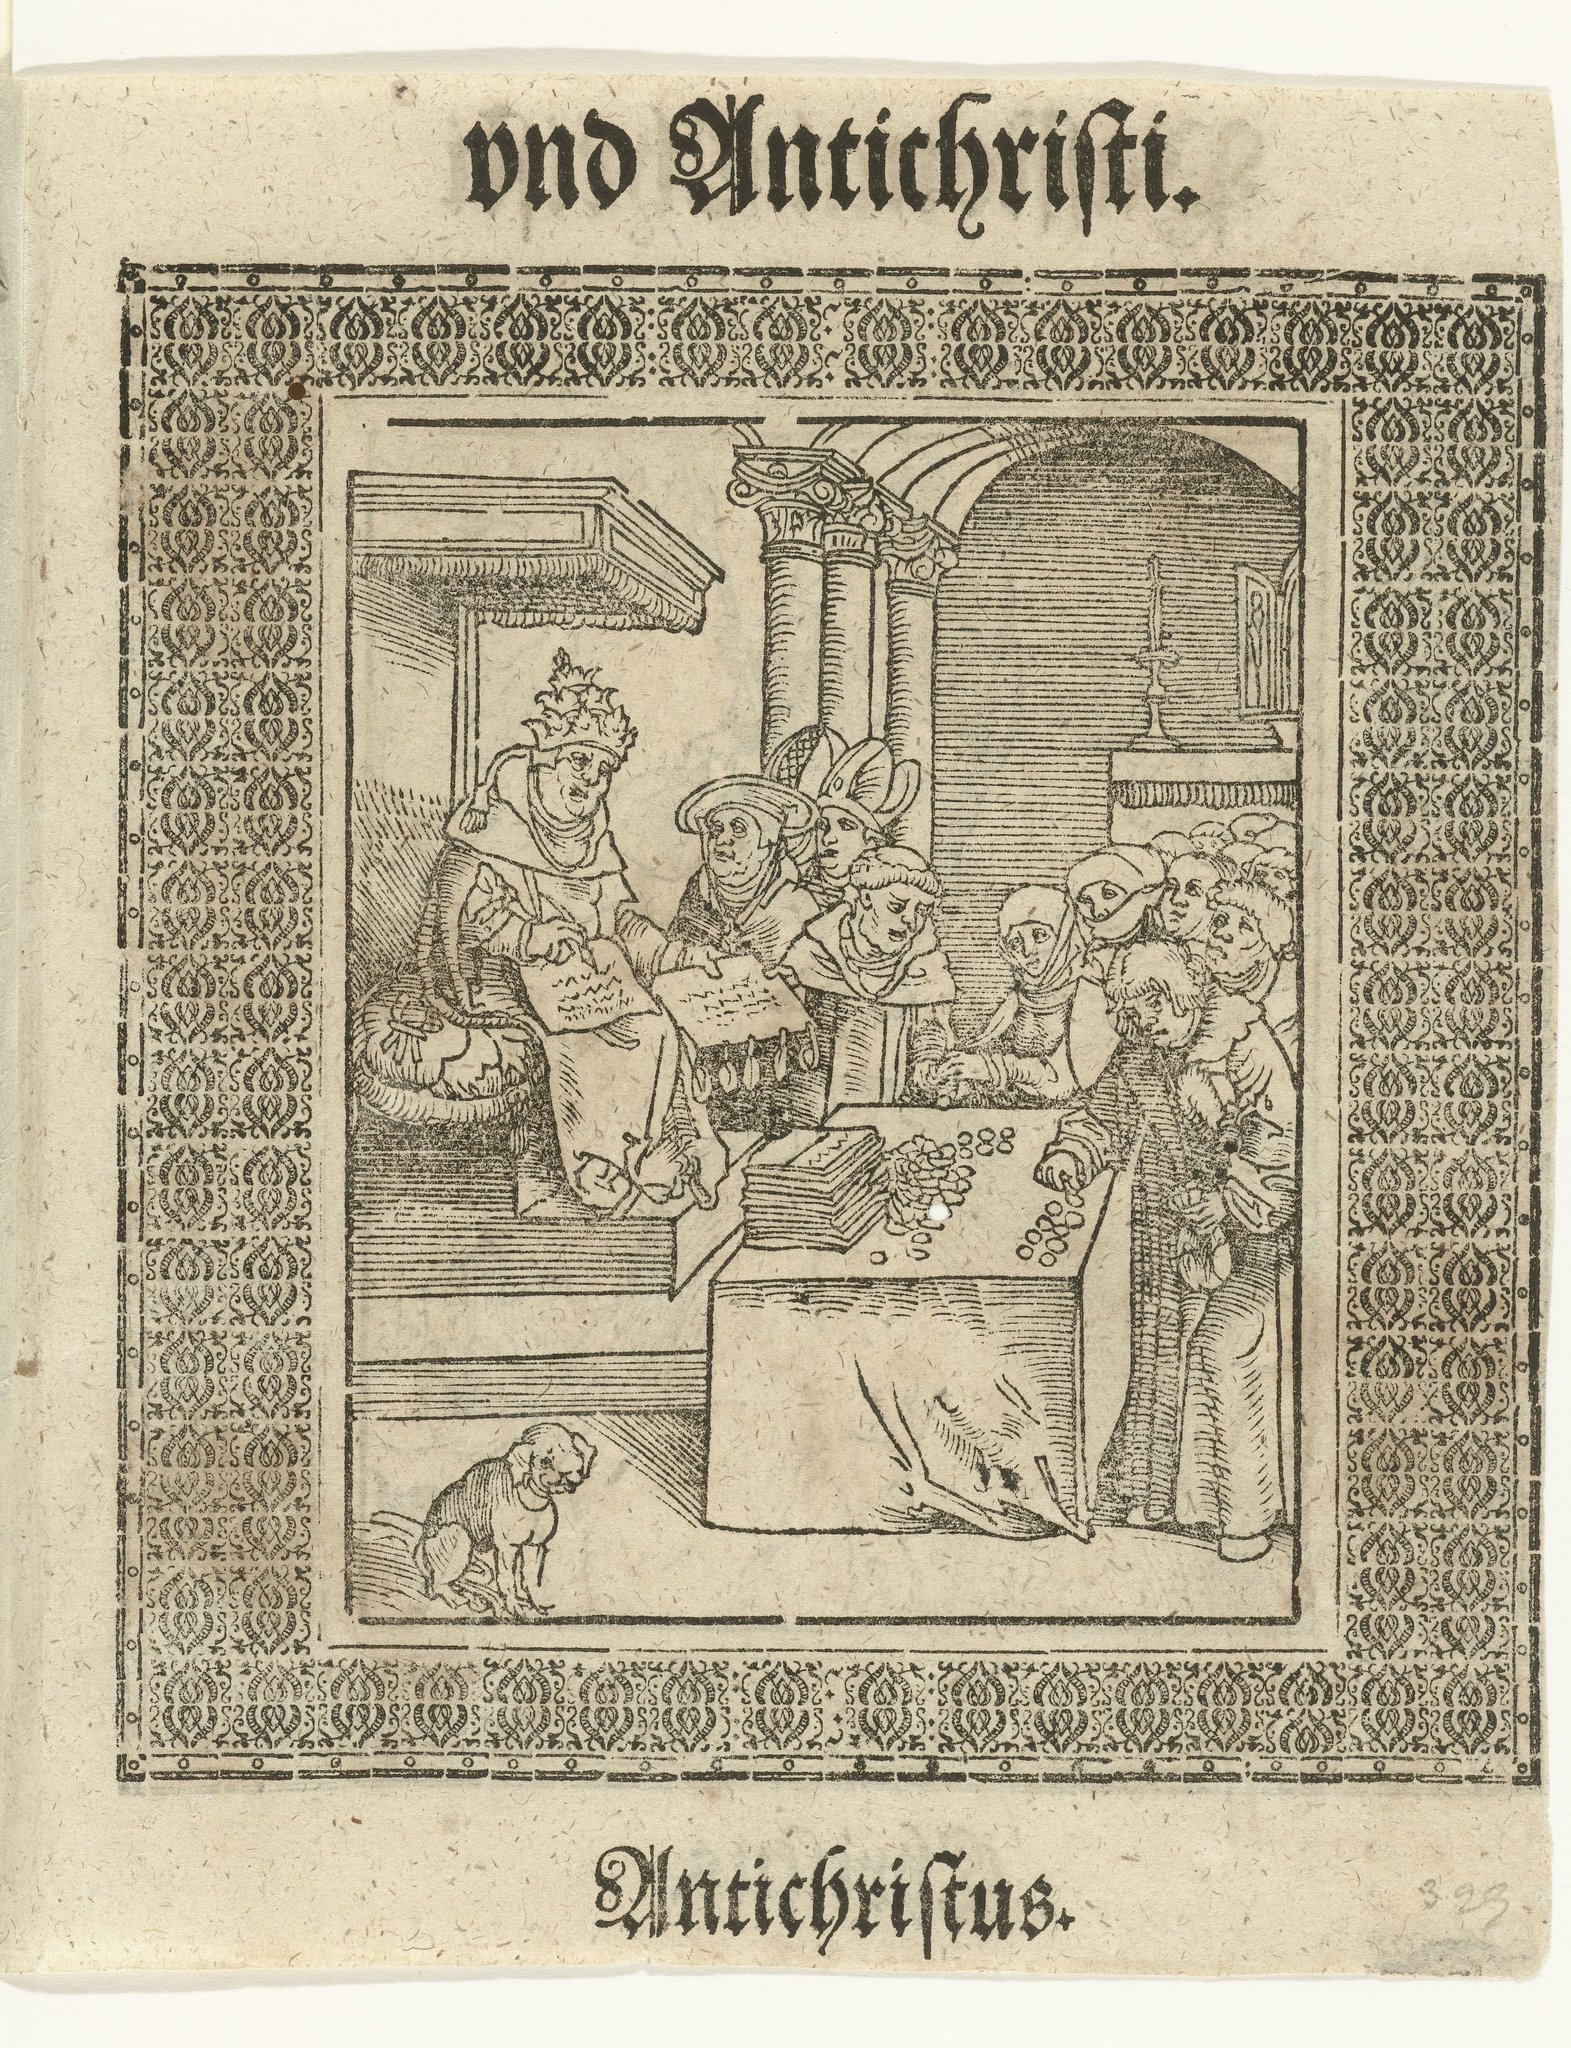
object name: print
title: Paus ontvangt aflaatgeld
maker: lucas cranach (i)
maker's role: draughtsman, print maker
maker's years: 1472-1553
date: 1521-1522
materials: paper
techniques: woodcut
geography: wittenberg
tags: absolution, forgiveness of sins ~ part of the confession, pope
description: De tegenhanger van deze prent is de voorstelling Christus verdrijft de geldwisselaars uit de tempel, RP-P-OB-4462(R). Blad uit: Passional Christi und Antichristi, Wittenberg 1521-1522, Johann Grünenberg. In 1521-1522 verschenen veel verschillende uitgaven van dit populaire werk van Maarten Luther. In de collectie van het RMA bevindt zich de complete serie van zesentwintig afbeeldingen uit een van deze uitgaven. De pagina's zijn op een kleiner formaat gesneden, onder iedere voorstelling stond oorspronkelijk een aantal regels Duitse tekst. De bladen hebben allemaal op dezelfde plaats twee kleine gaatjes van vraat door ongedierte wat er op wijst dat ze behoren tot hetzelfde exemplaar.